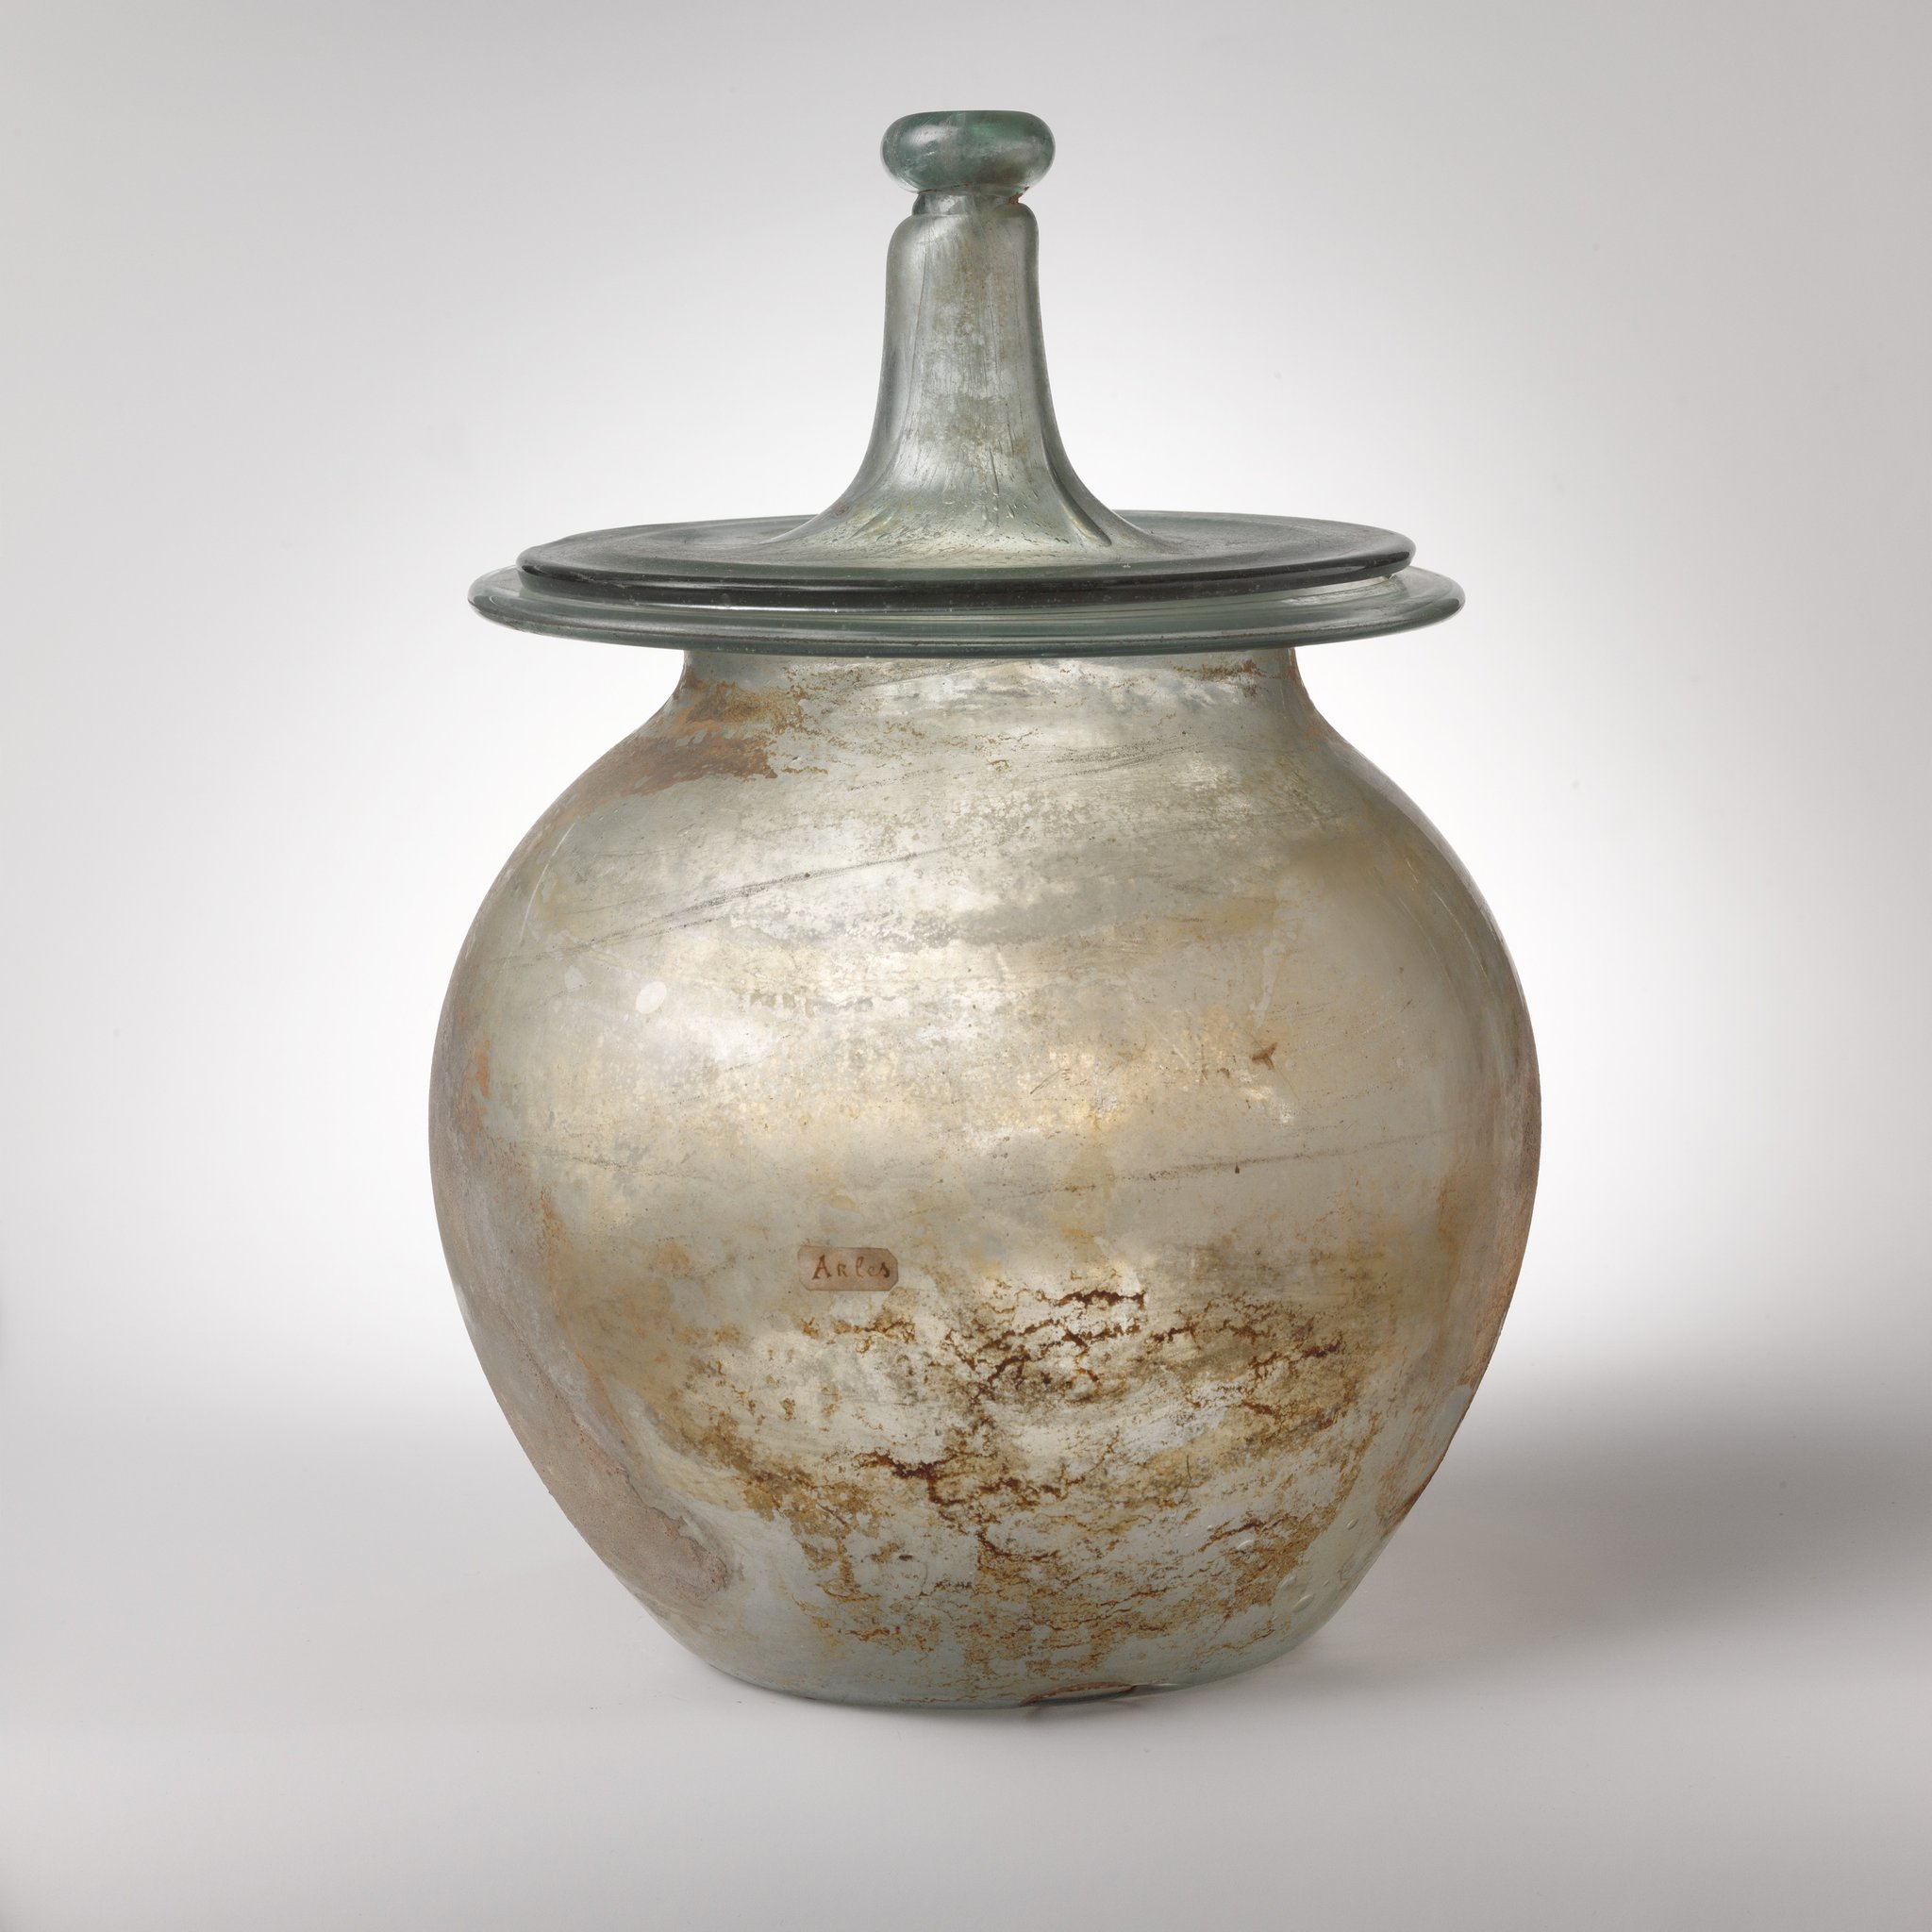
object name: urn with lid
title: Glass cinerary urn with lid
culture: roman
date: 34-200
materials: glass